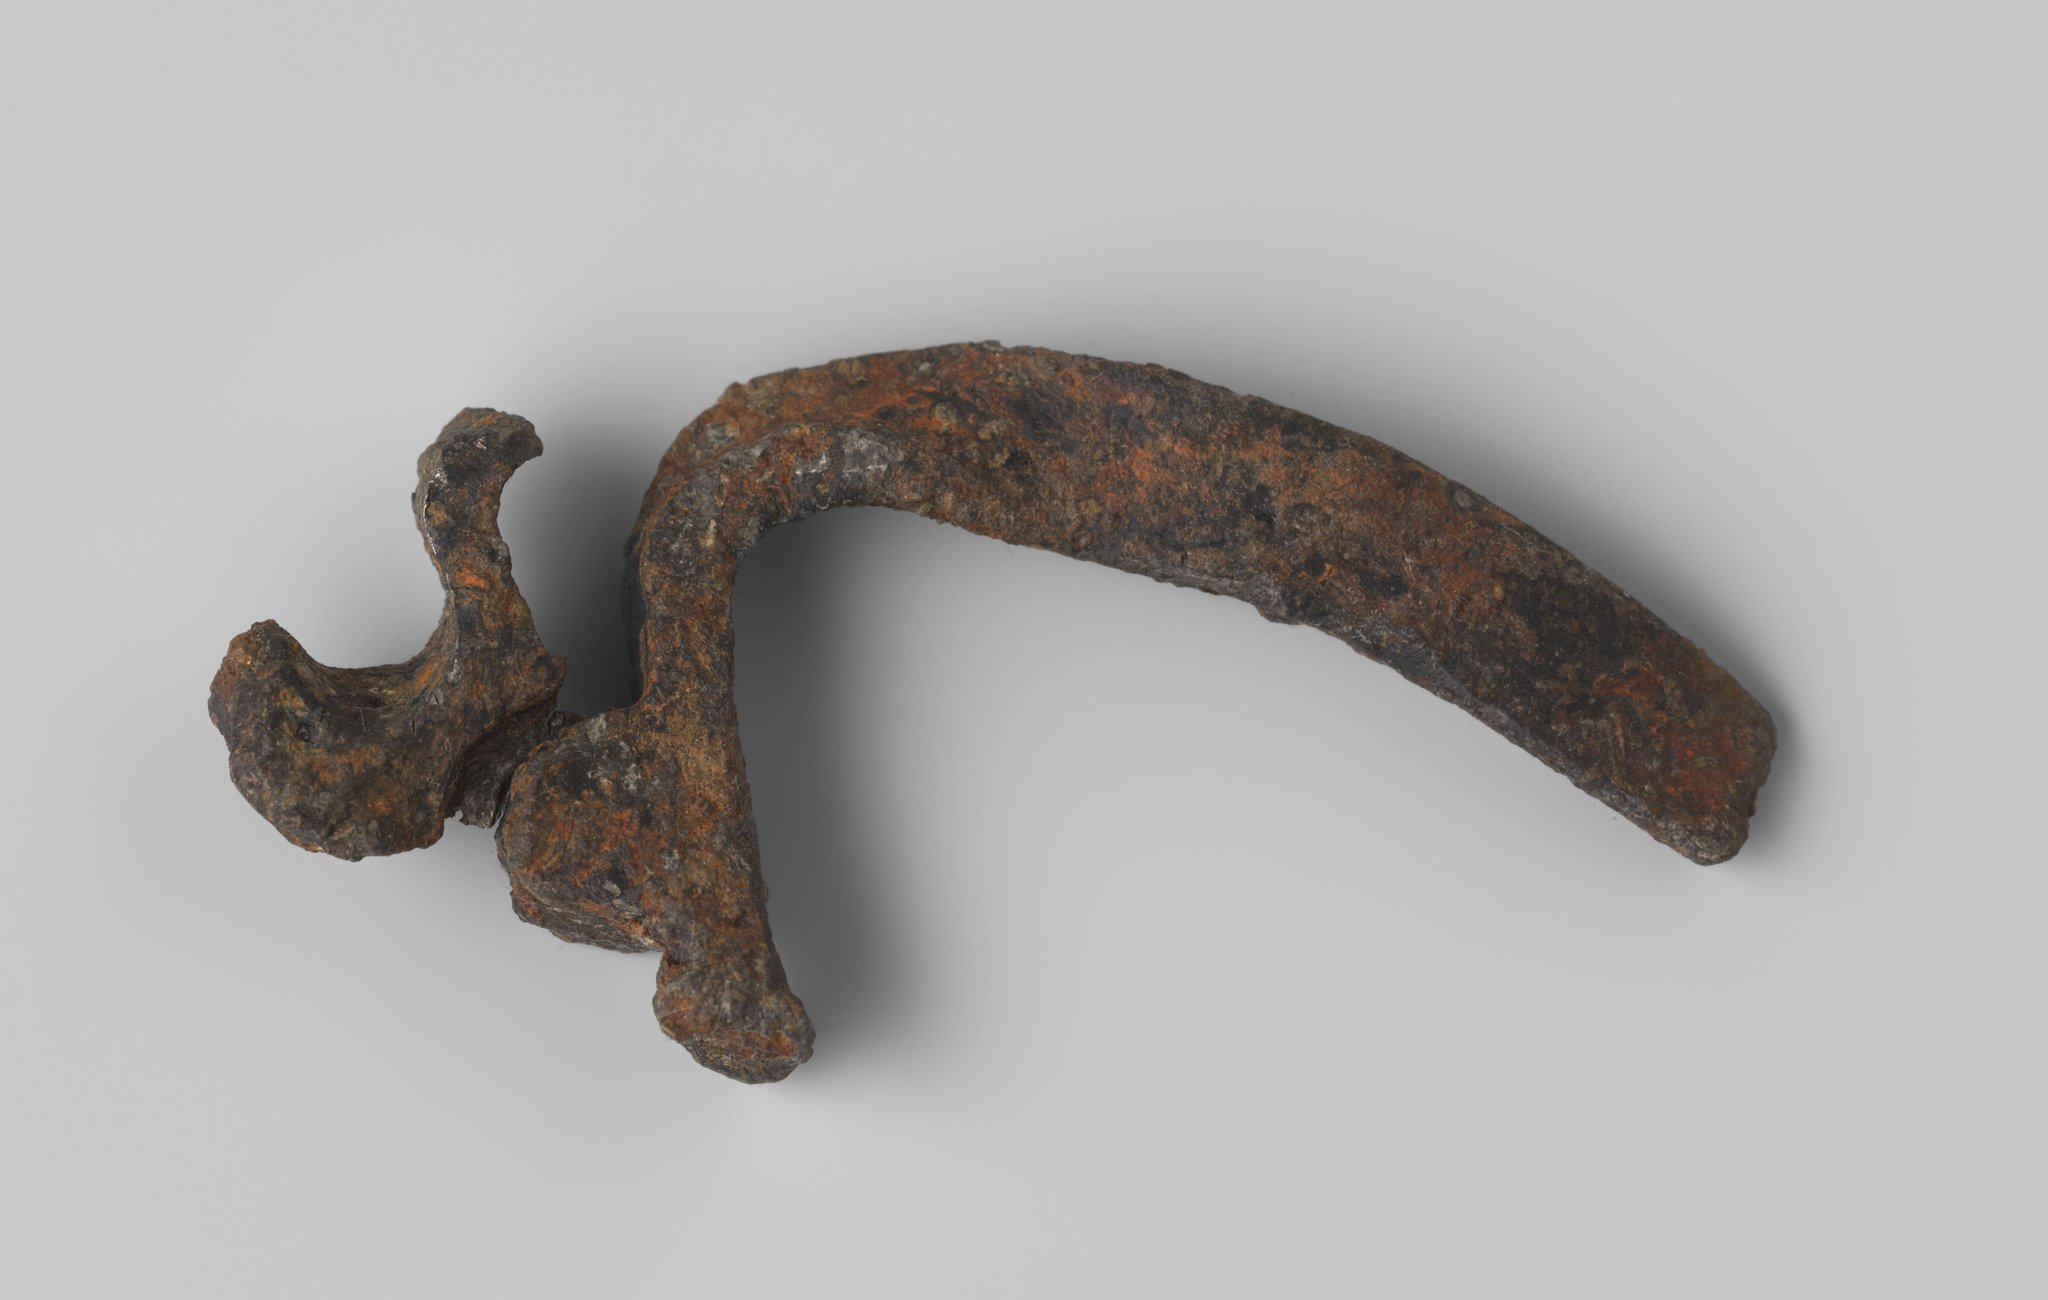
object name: lug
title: Oor van een kan uit het wrak van de Oost-Indiëvaarder Hollandia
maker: Anonymous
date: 1700-1743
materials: tin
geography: netherlands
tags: verenigde oostindische compagnie, hollandia (schip), annet